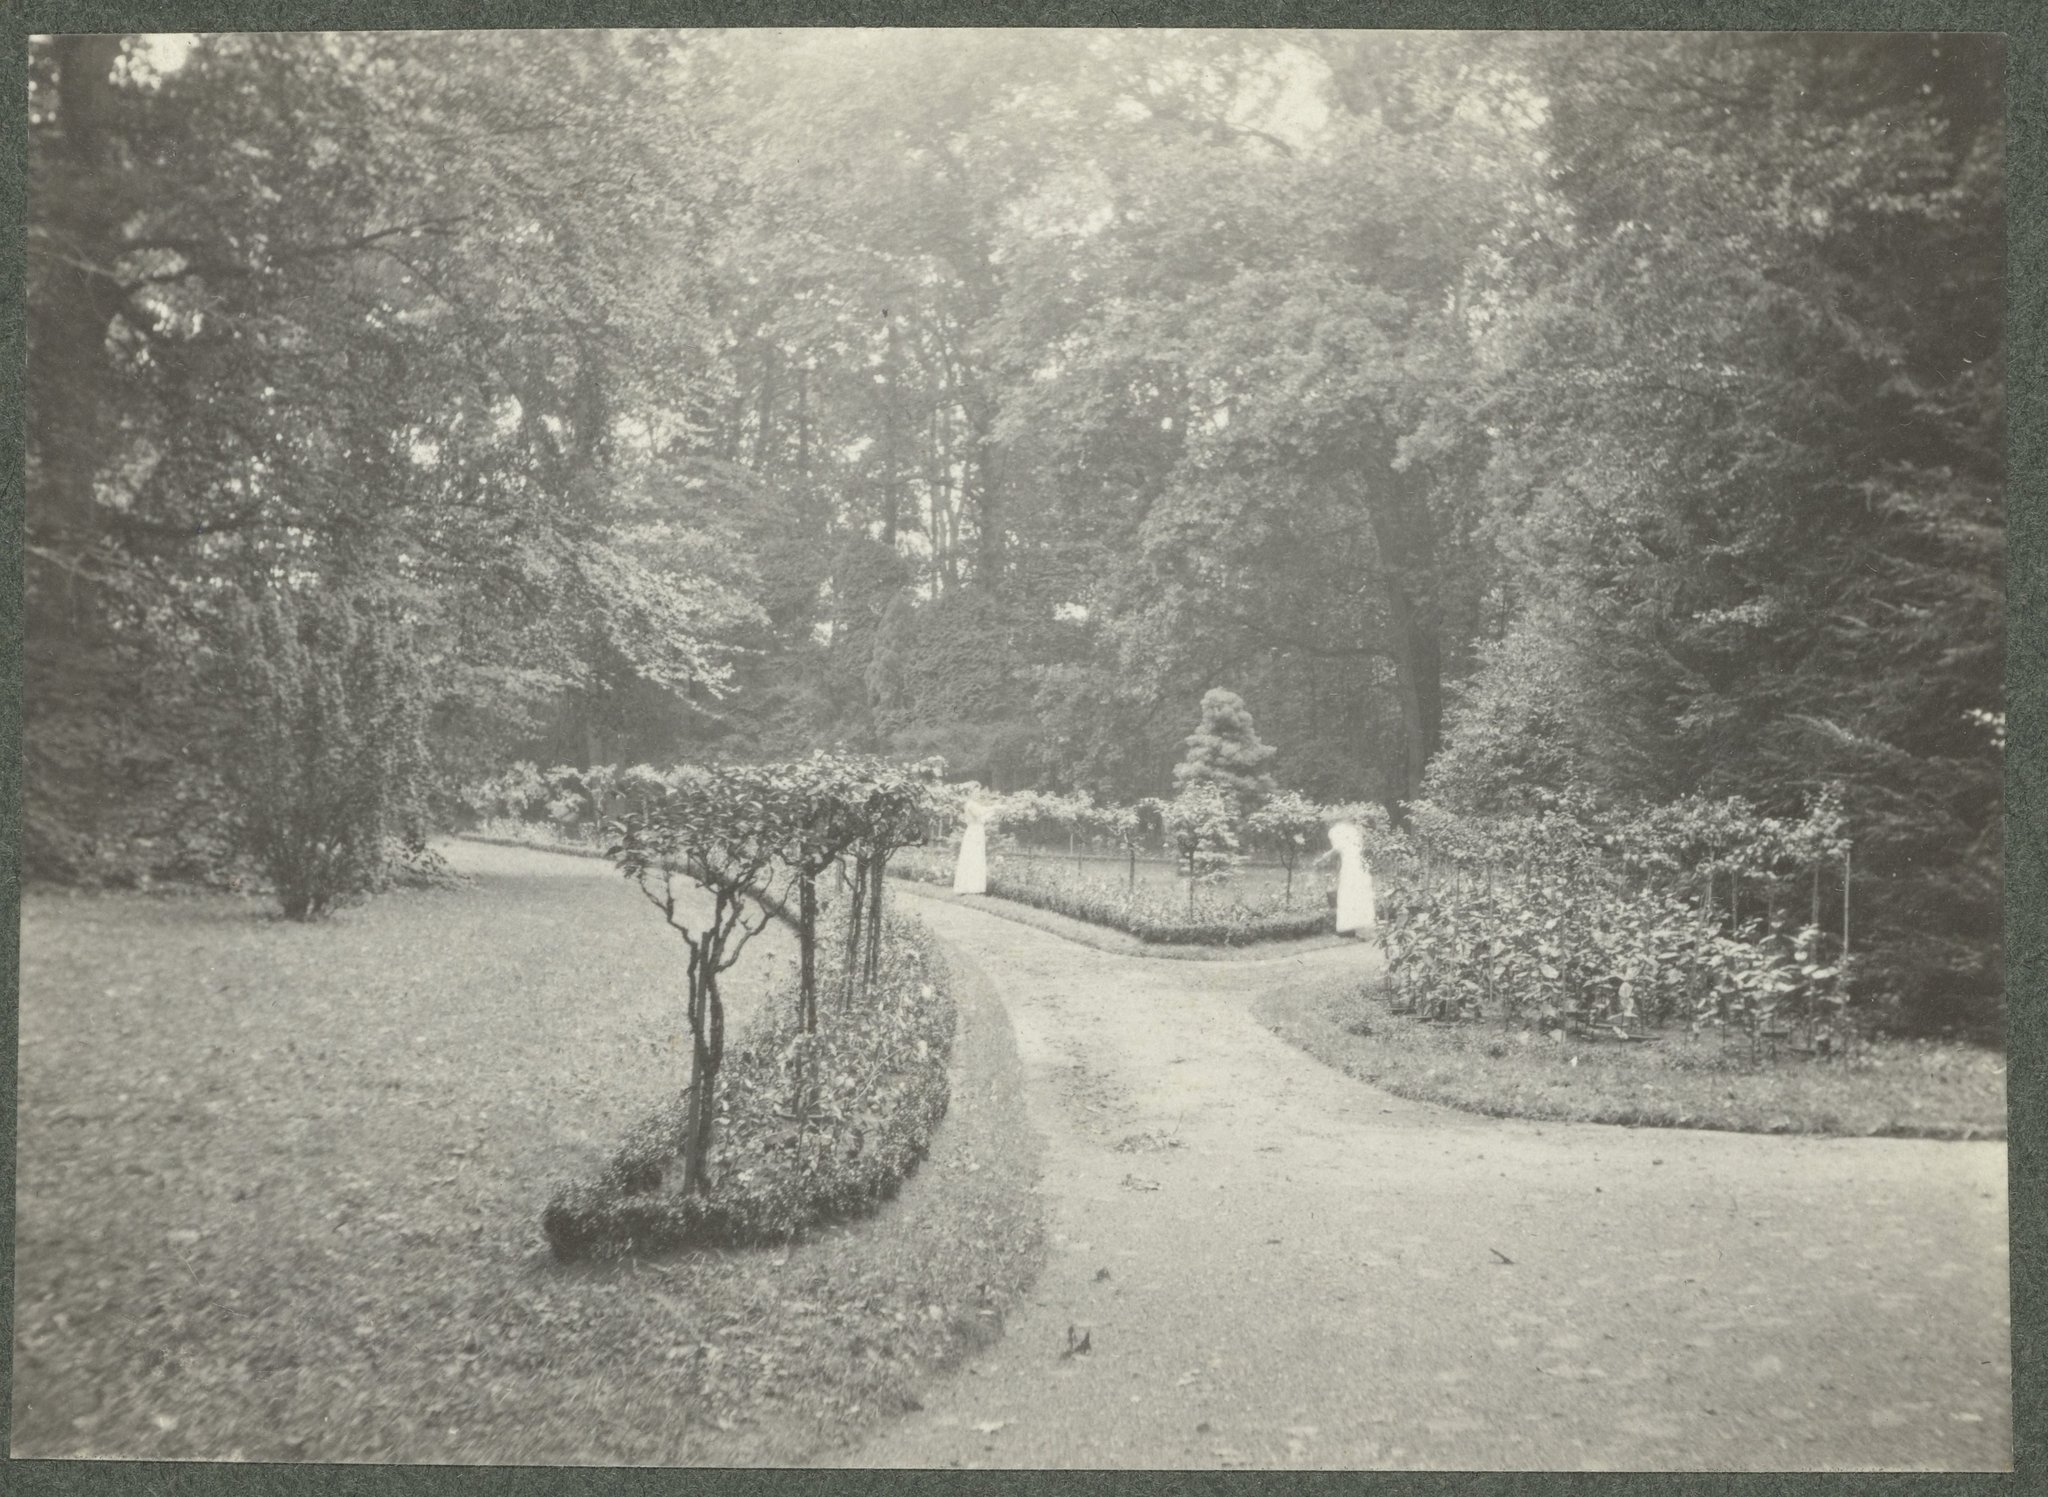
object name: photograph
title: Tuinpad van Landgoed De Paauw met aan weerszijden beplanting in een bosrijke omgeving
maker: geldolph adriaan kessler (dolph)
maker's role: fotograaf, industrieel, voetballer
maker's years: 1884-1945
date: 1913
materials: paper, photographic support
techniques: gelatin silver print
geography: netherlands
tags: huize de paauw